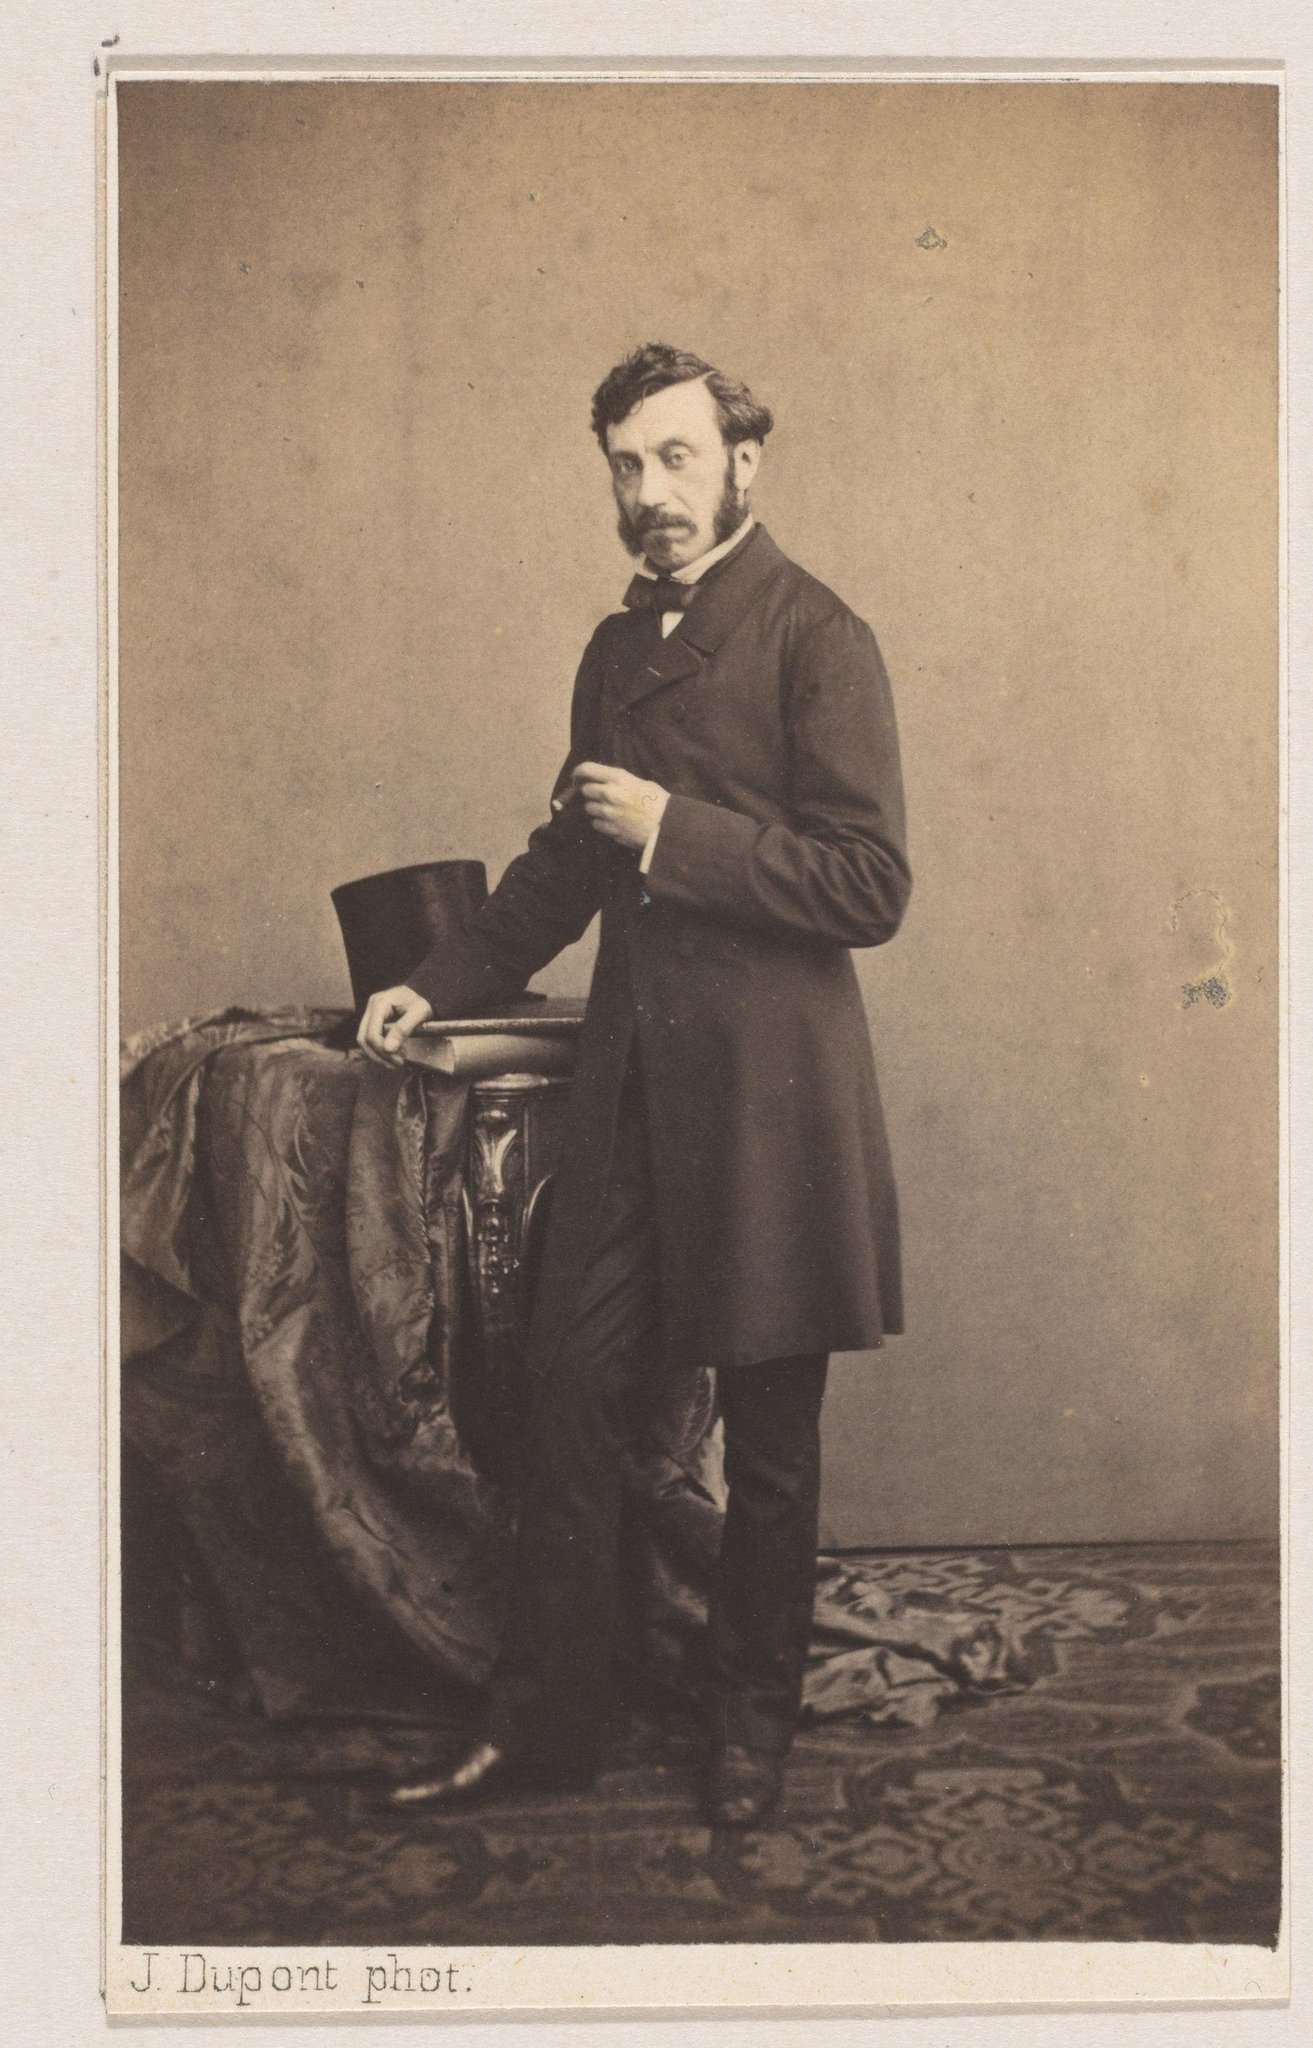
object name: photograph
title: Portret van de schilder Louis de Winter, ten voeten uit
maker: joseph dupont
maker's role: fotograaf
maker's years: 1818-1901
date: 1861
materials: cardboard, paper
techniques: albumen print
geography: antwerp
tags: antwerp, painter, louis de winter, historical persons, portrait, self-portrait of painter, portrait, self-portrait of artist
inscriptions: inscription: ‘Etablissement Photographique/ DE/ J. DUPONT/ Place de Meir, 32,/ ANVERS./ Maison fondée en 1853’